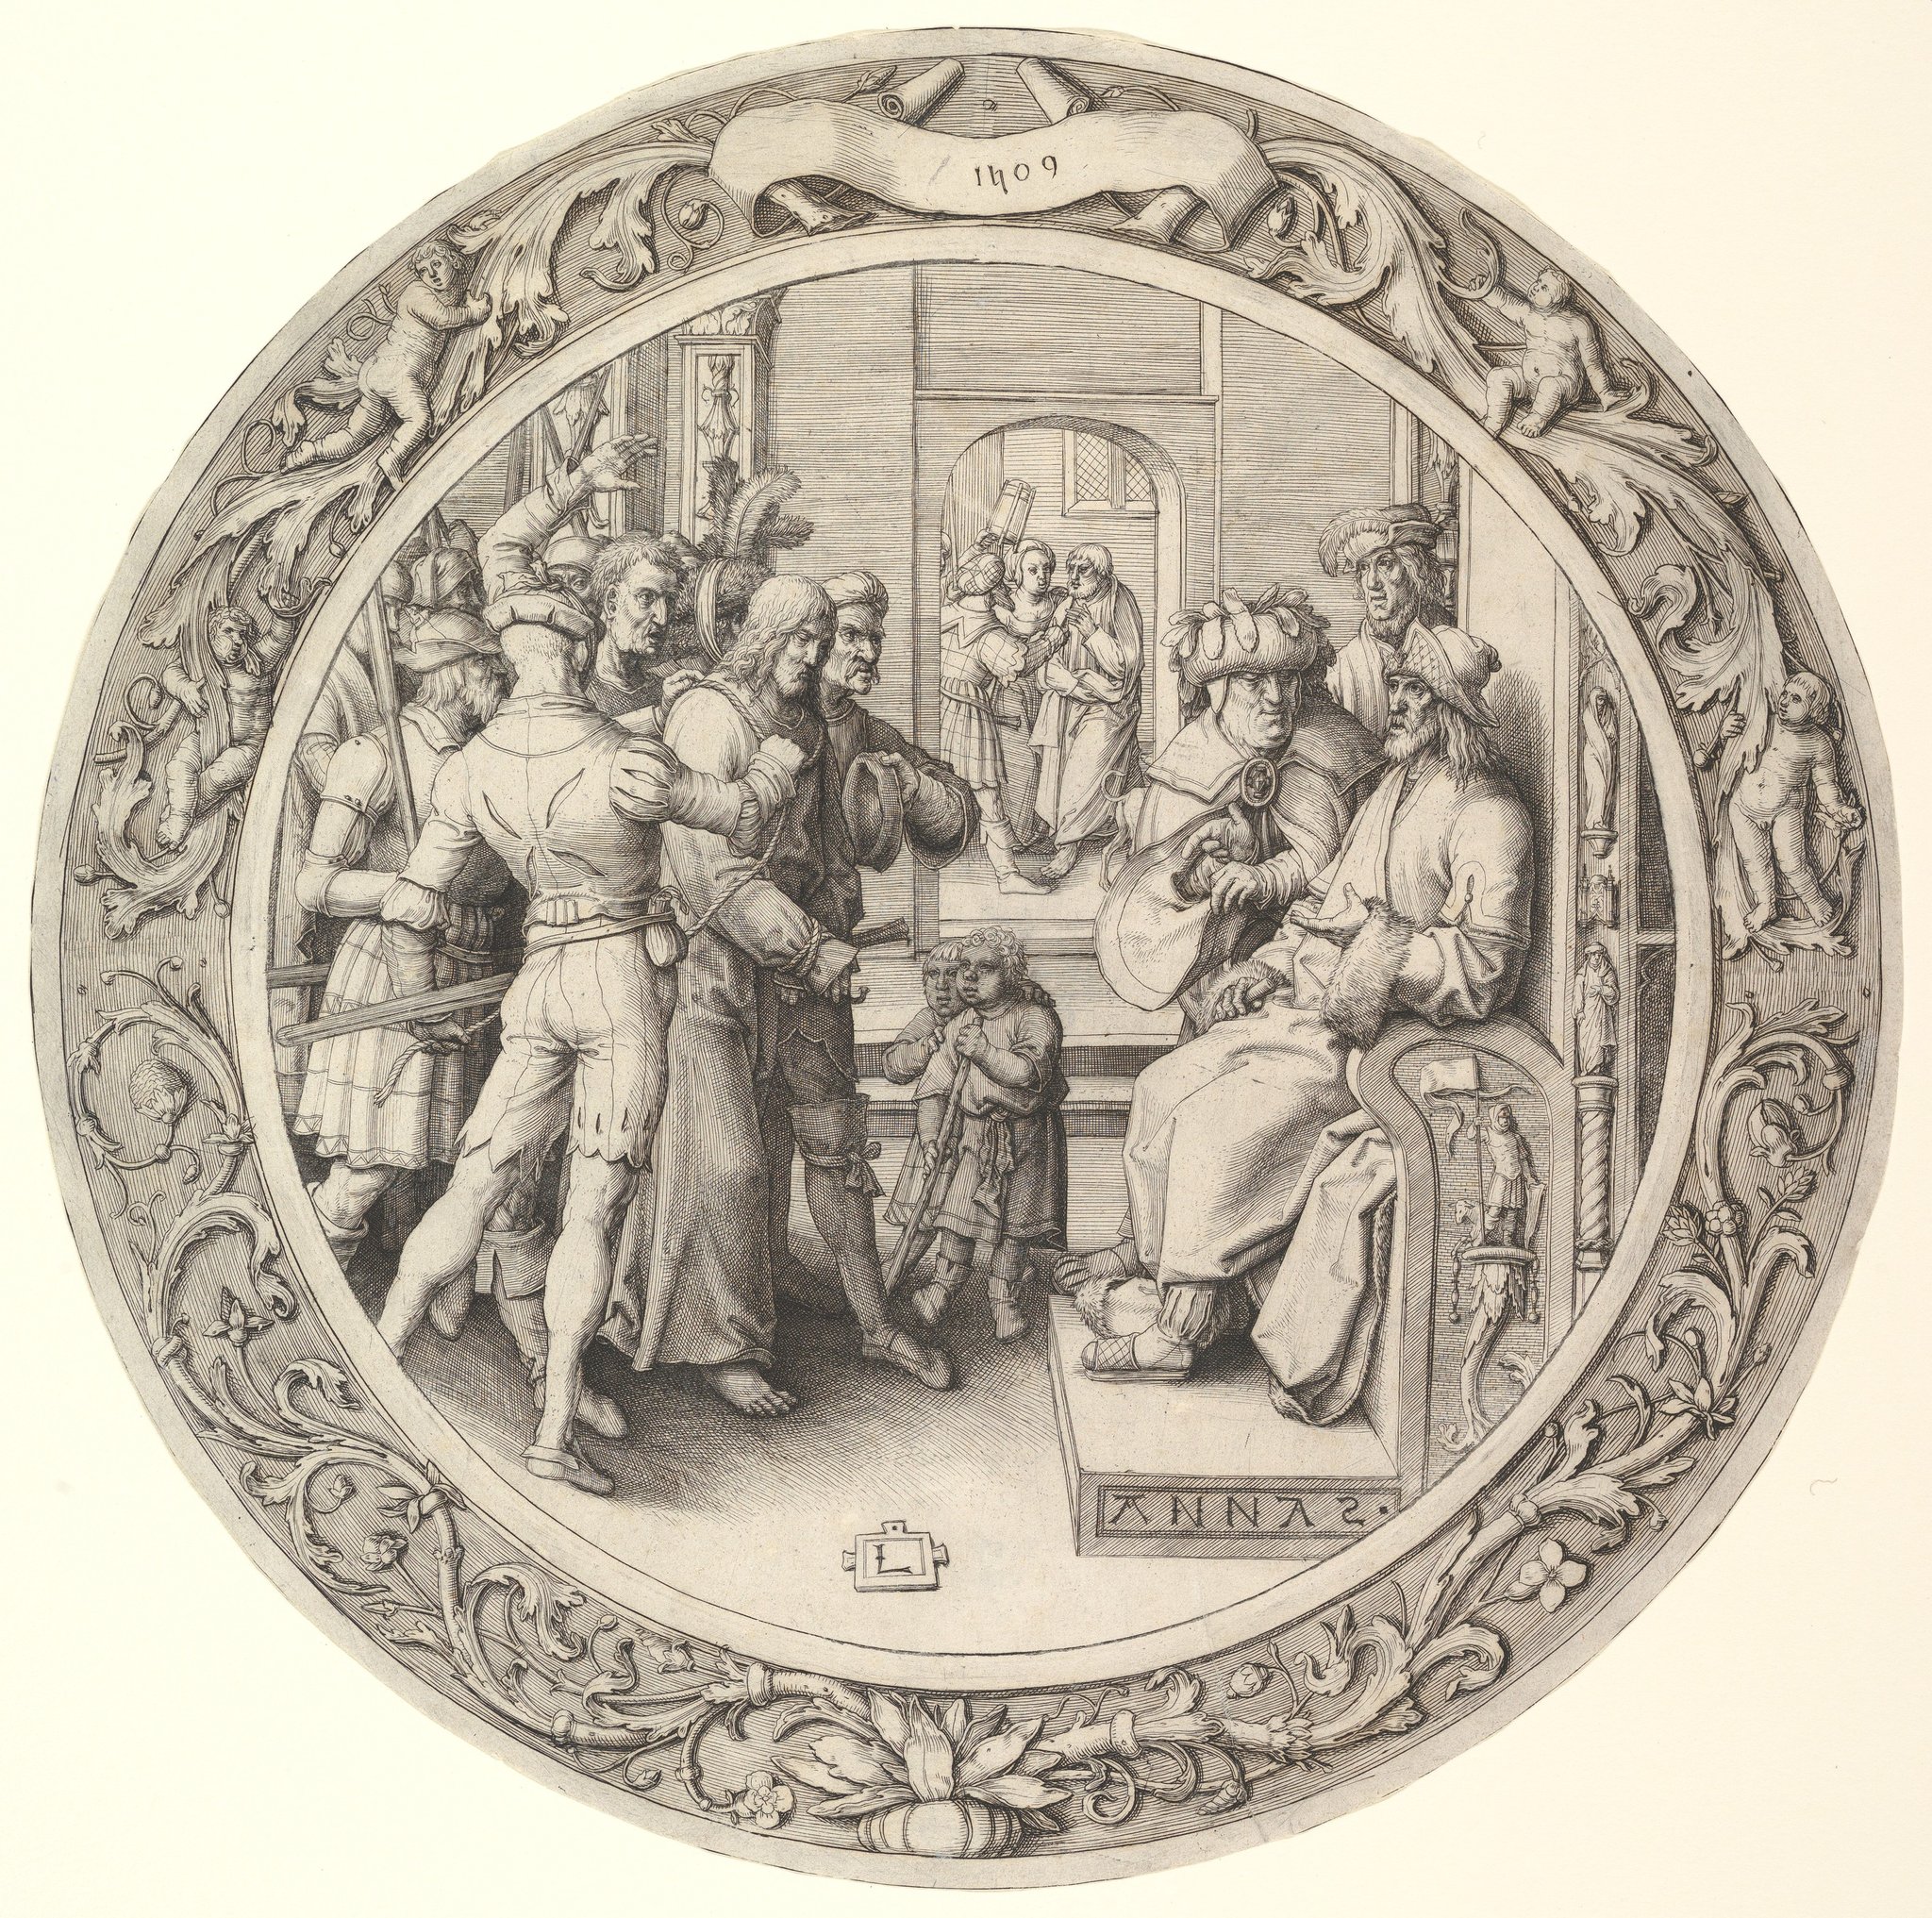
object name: print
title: Christ before Annas, from the Circular Passion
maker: lucas van leyden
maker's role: artist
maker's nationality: netherlandish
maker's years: 1494-1533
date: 1509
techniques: engraving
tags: christ